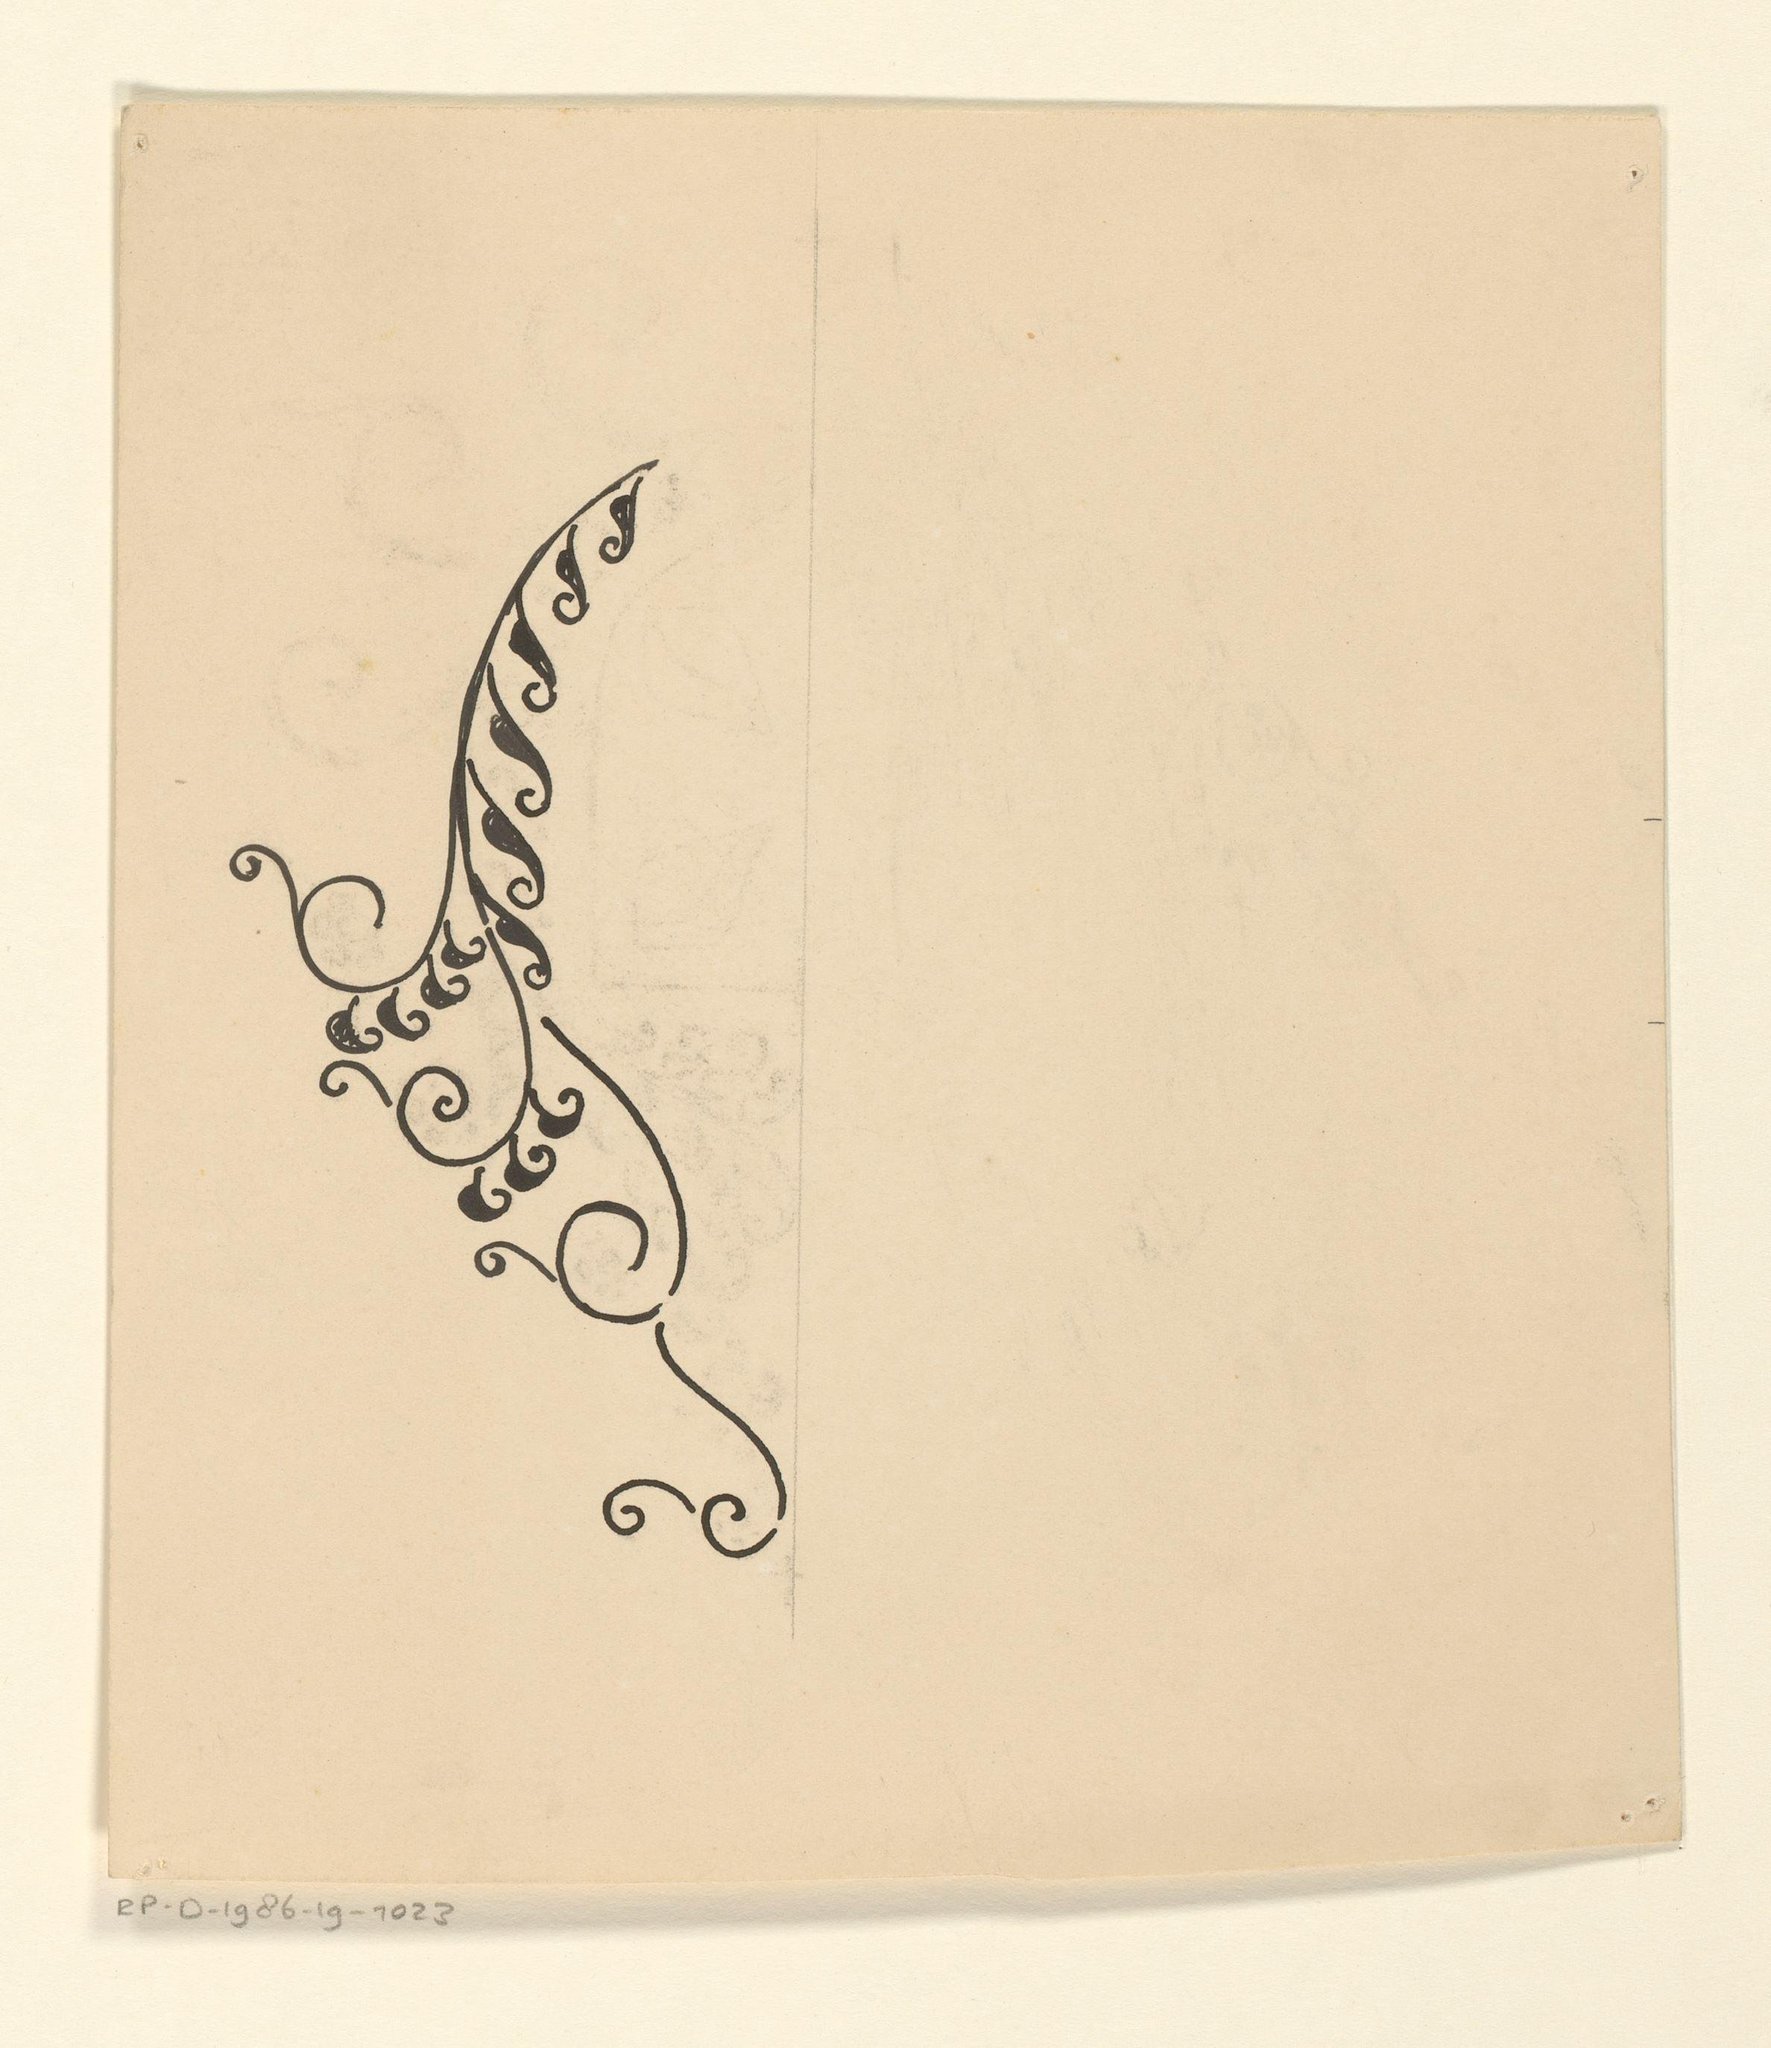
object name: drawing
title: Ontwerp voor een ornamenteel kader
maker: reinier willem petrus de vries (1874-1953)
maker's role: draughtsman, print maker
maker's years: 1874-1953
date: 1884-1952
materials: ink, paper, pencil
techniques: pen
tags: flowers ~ ornament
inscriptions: collector's mark: ‘R:MVS.’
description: Vermoedelijk een ontwerp voor: Ravesteijn, P.J. Gedenkboek Hilversum 1424-1924. Hilversum: Gemeente Hilversum, 1924.